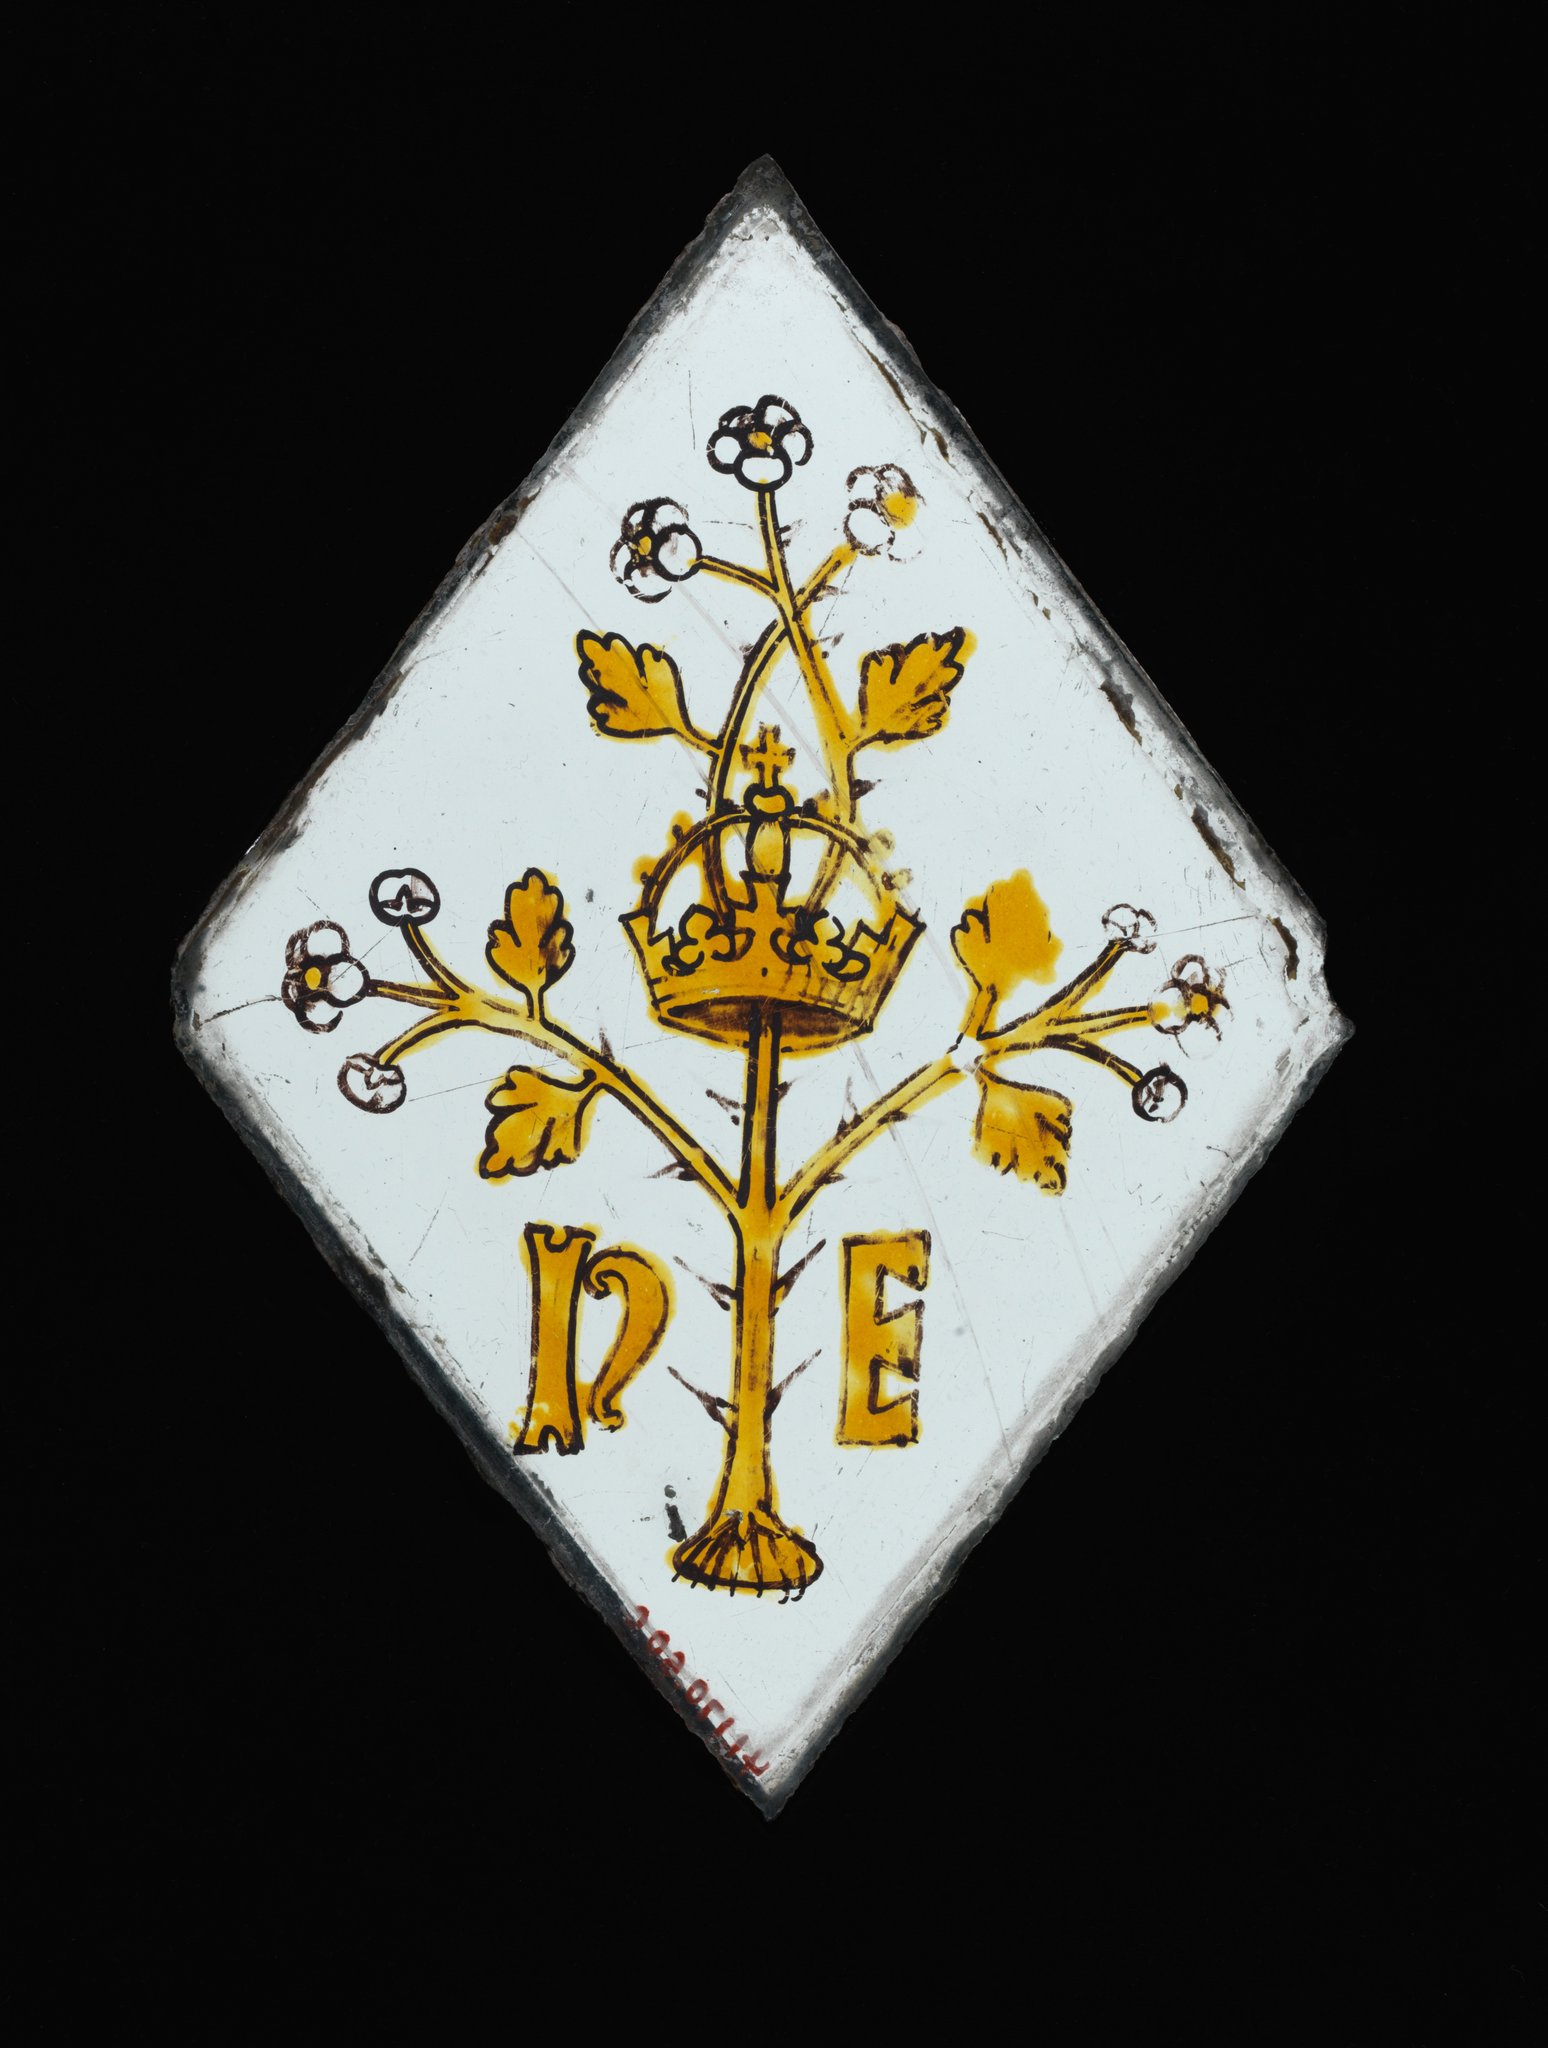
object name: quarry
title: Quarry (one of a pair)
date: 1501-1533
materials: glass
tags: crowns